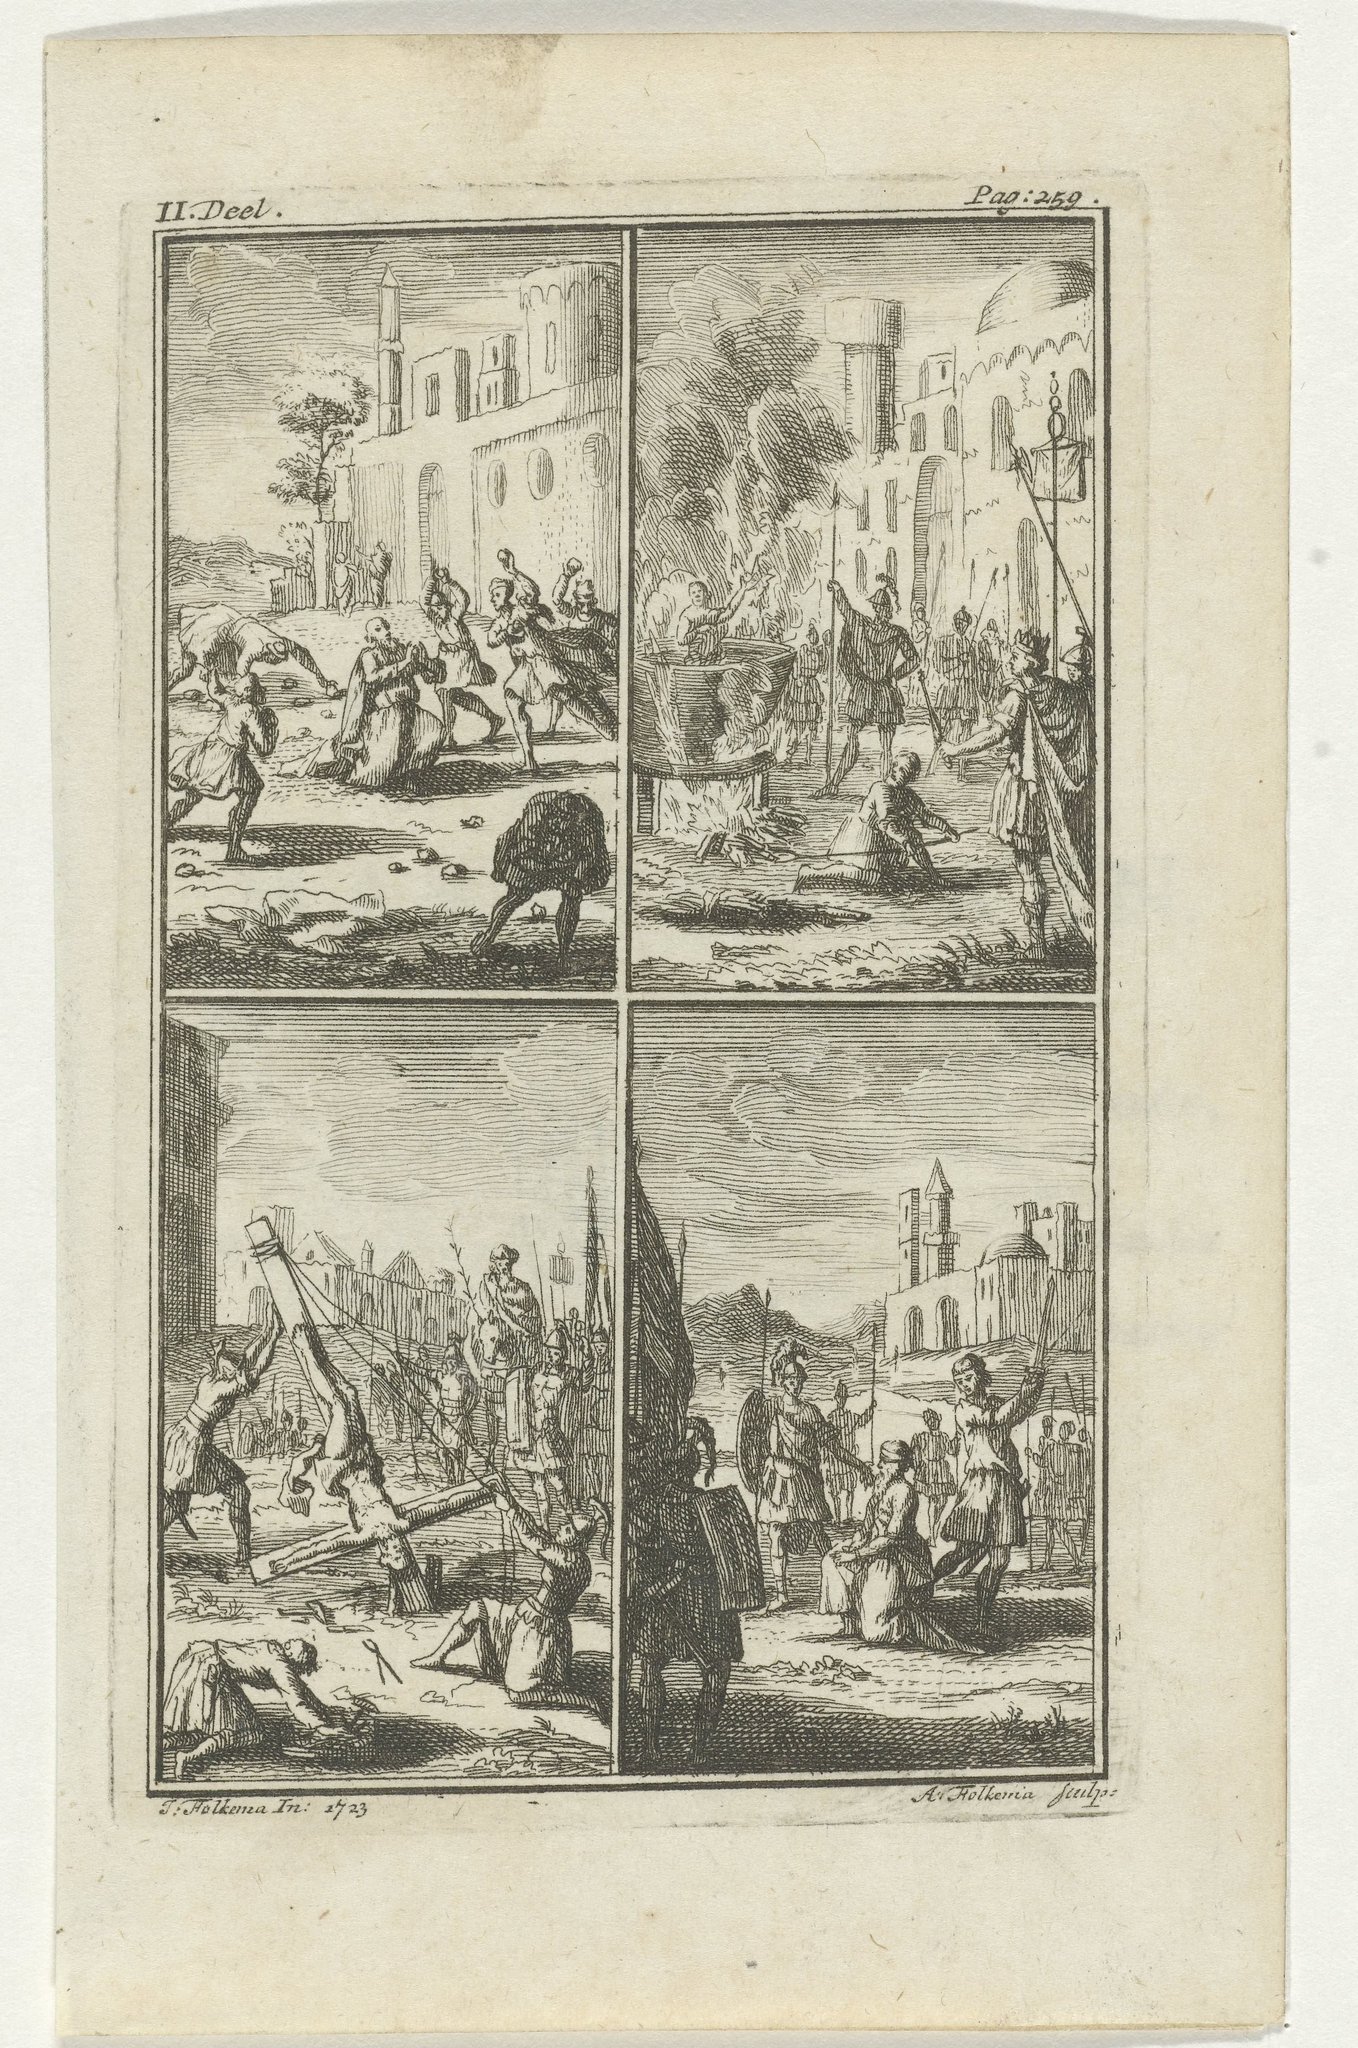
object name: text sheet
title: Tekstblad bij boekillustratie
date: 1723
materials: paper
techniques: letterpress printing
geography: amsterdam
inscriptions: collector's mark: Lugt 2760, collector's mark: Lugt 2228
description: Tekstblad uit: Leuve, Roeland van. 's Waerelds koopslot of De Amsteldamse beurs. Amsterdam: Jacobus Verheyden (I), 1723.